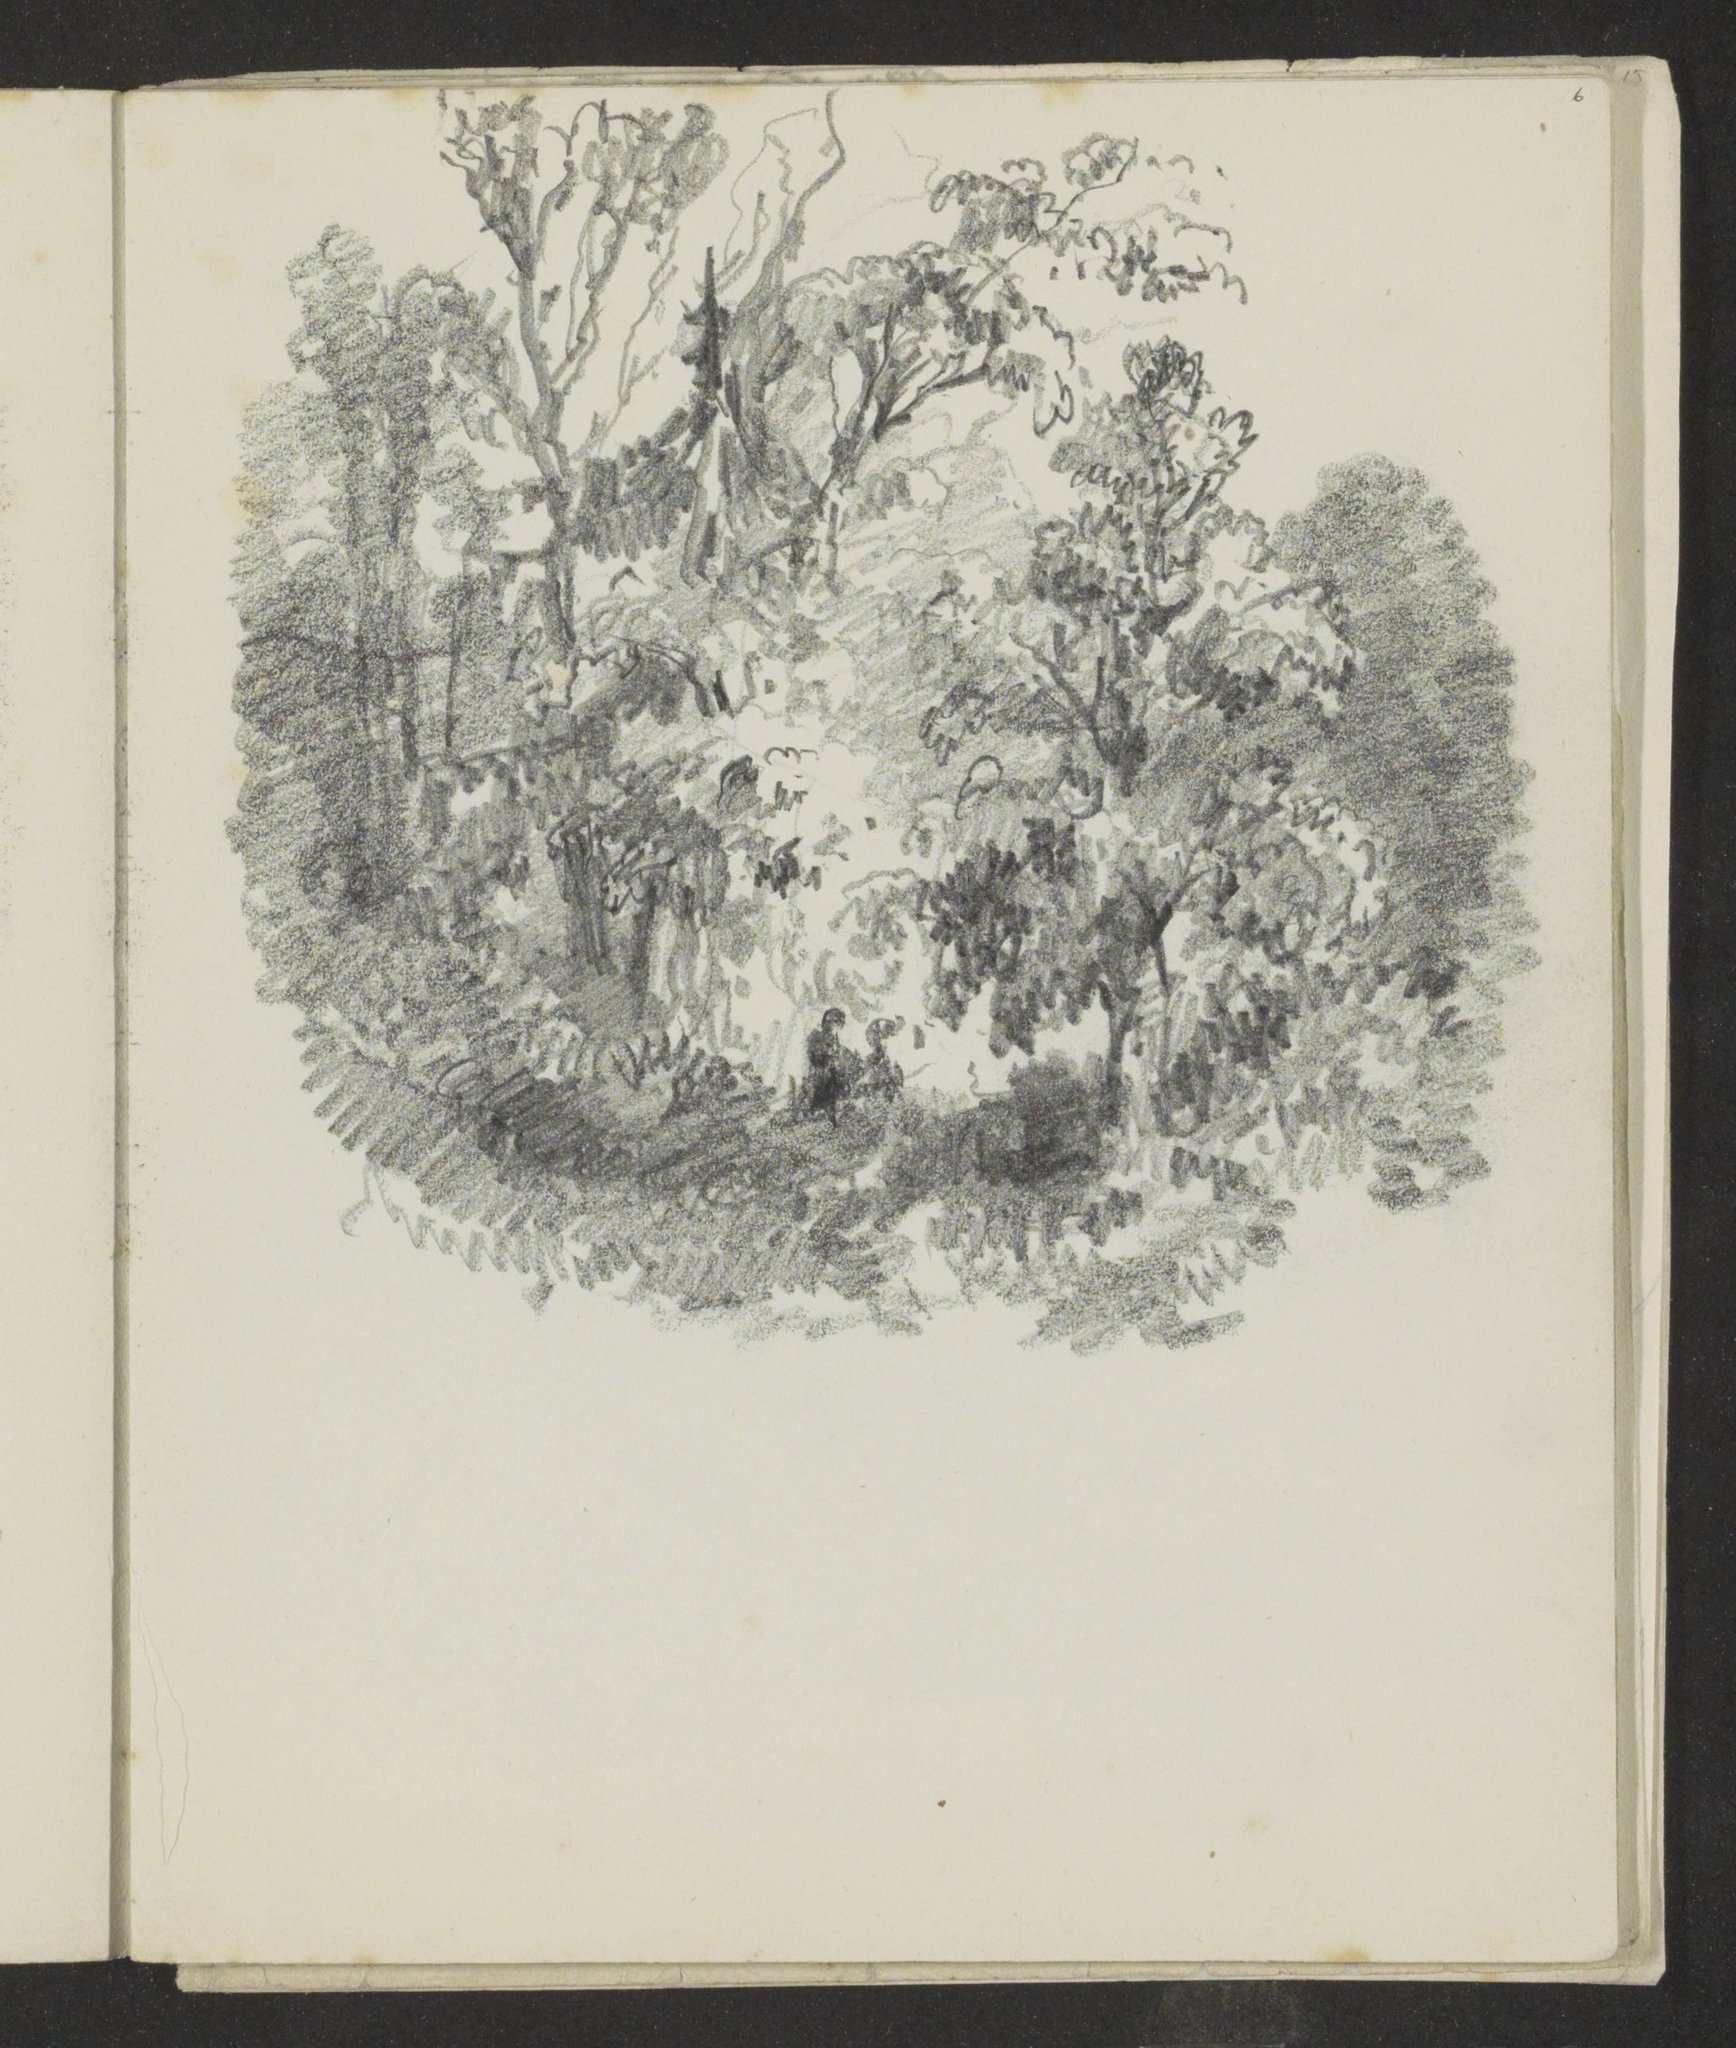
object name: sketchbook leaf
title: Bos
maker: maria vos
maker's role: draughtsman, painter, print maker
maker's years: 1824-1906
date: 1834-1906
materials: paper, pencil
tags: forest, wood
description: Blad 6 recto uit een schetsboek met 17 bladen.